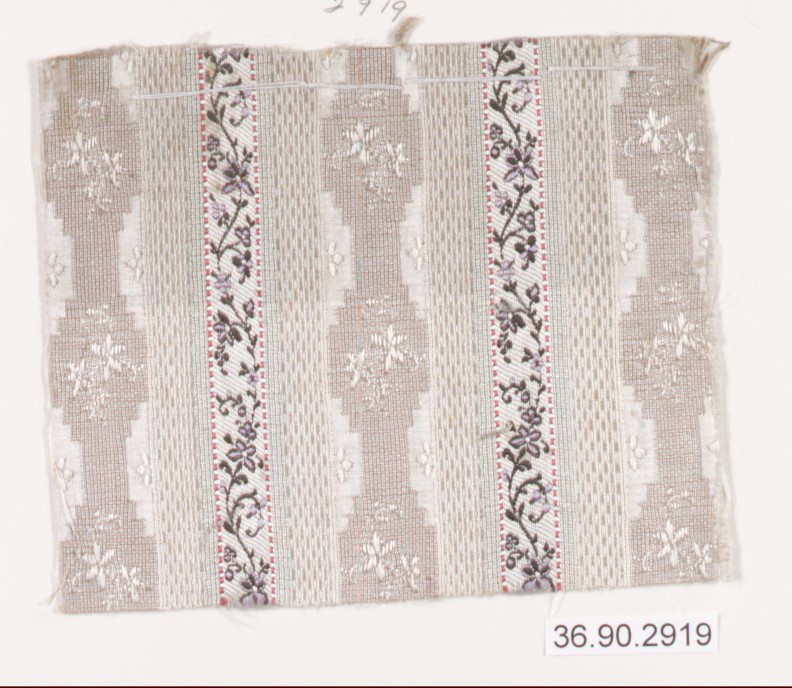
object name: piece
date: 1801-1900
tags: flowers,leaves